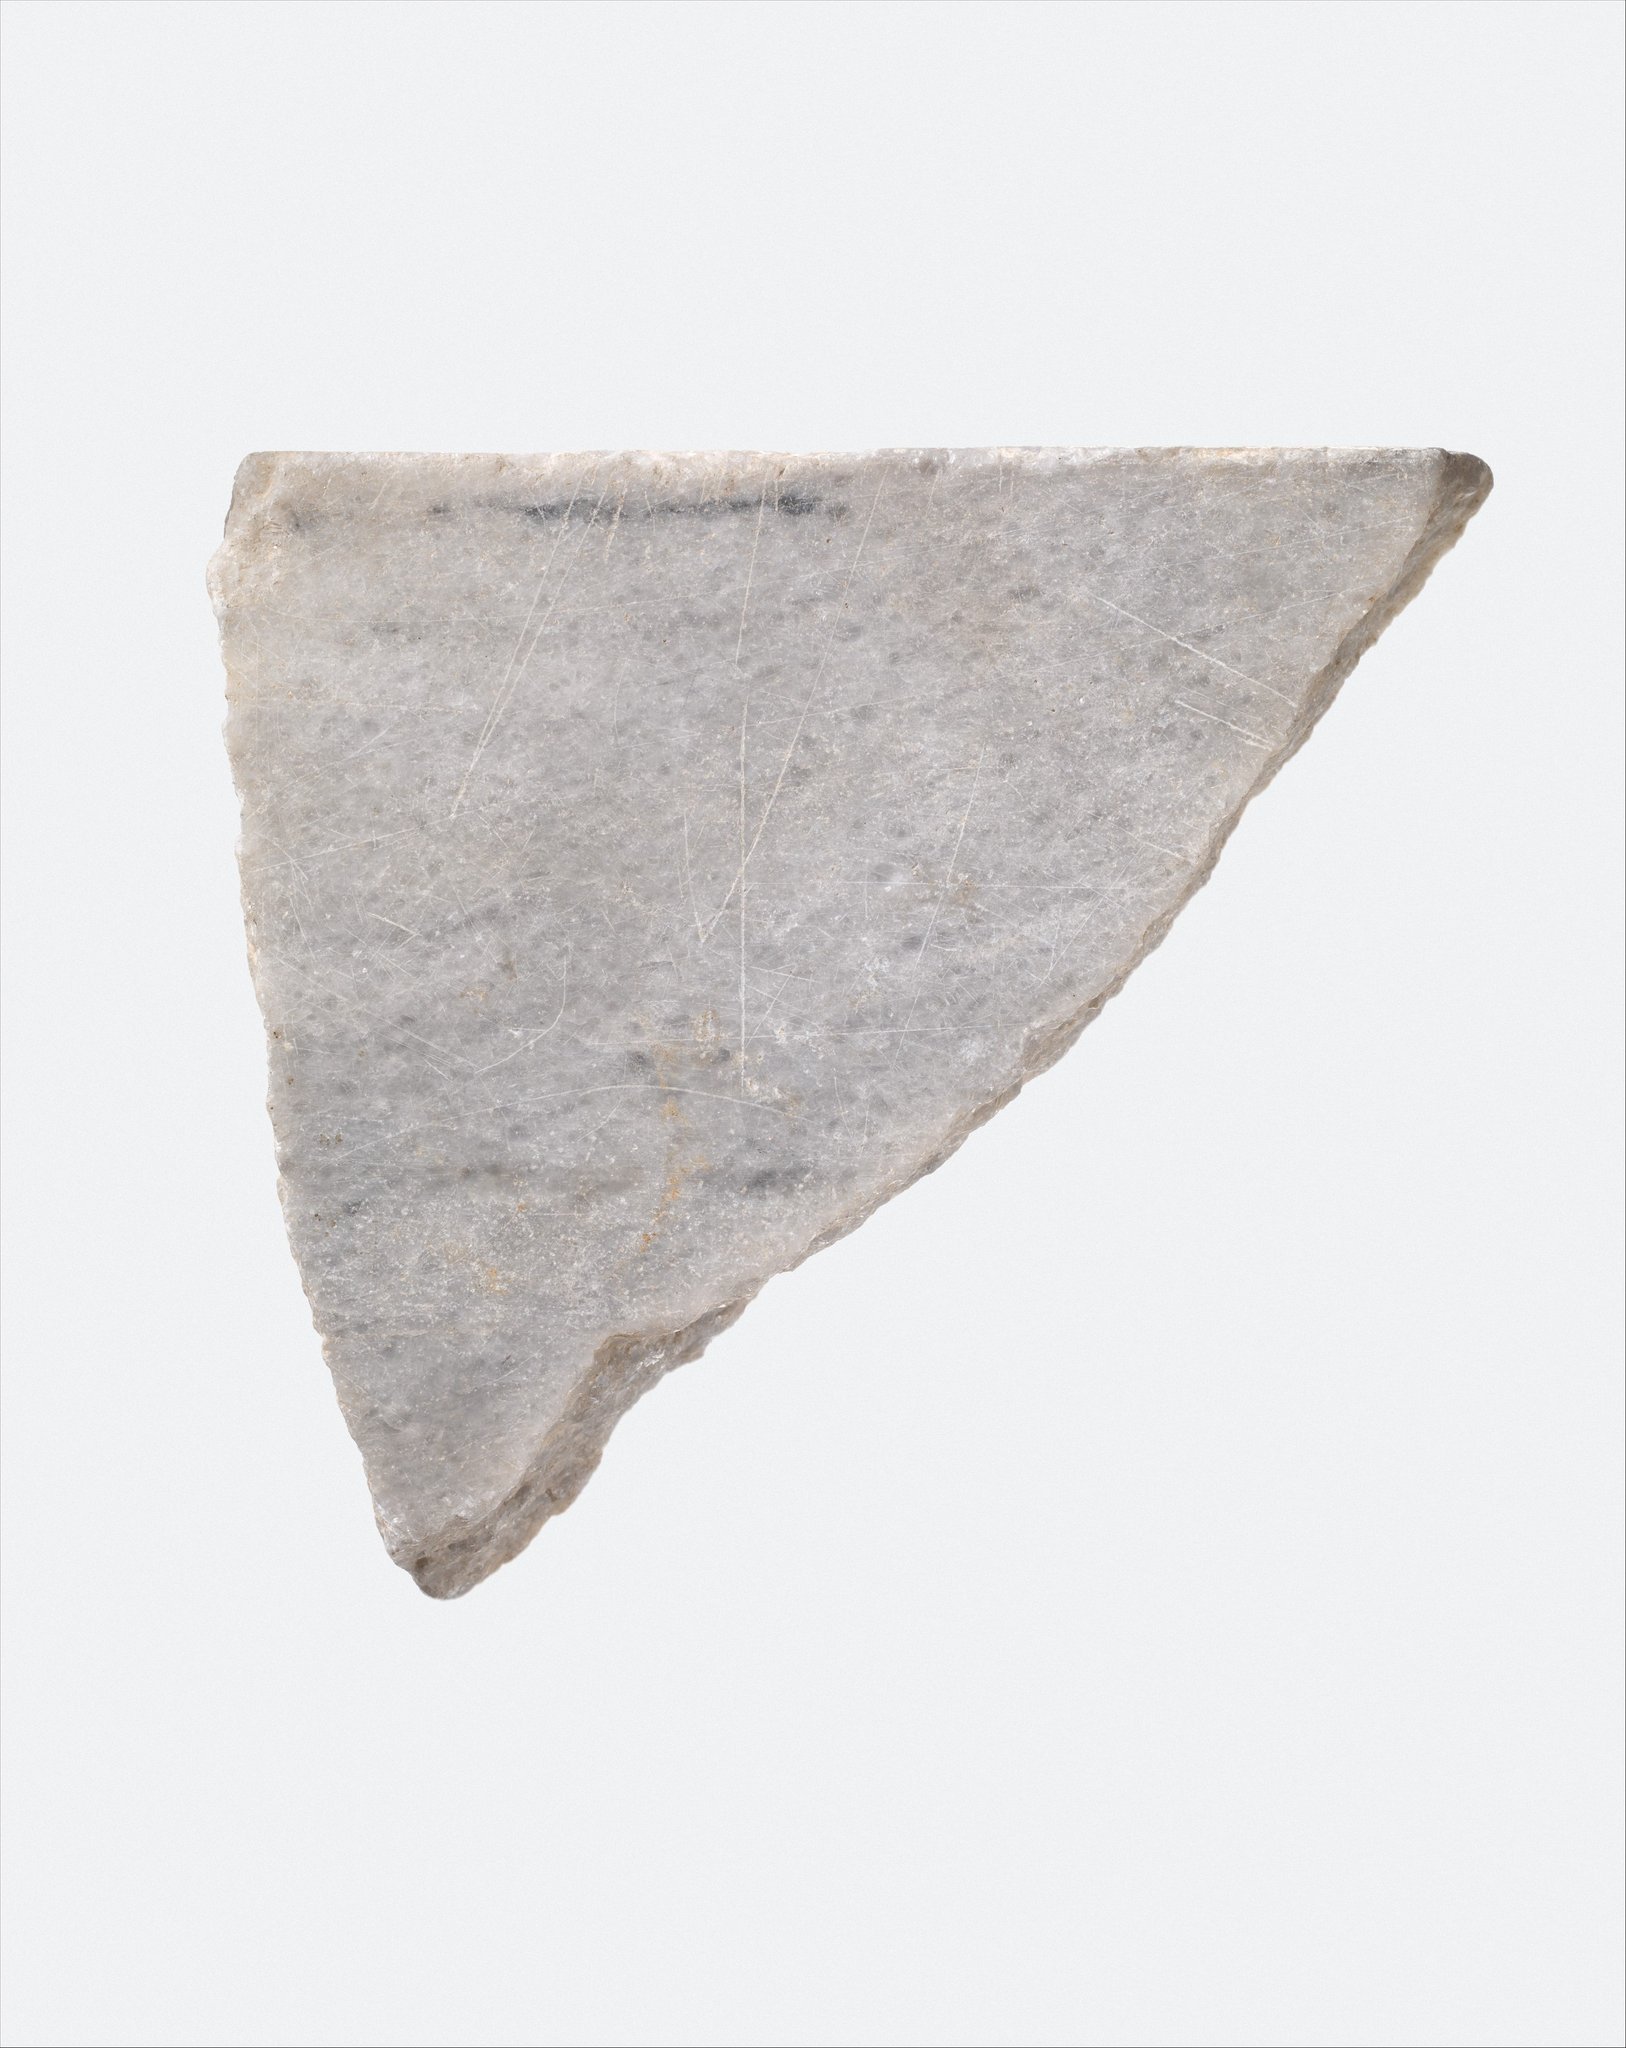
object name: plaque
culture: sasanian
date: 201-700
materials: marble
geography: mesopotamia